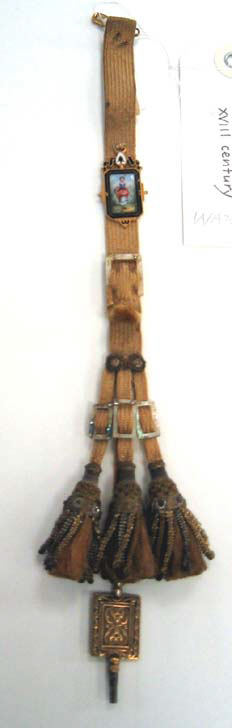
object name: fob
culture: french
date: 1701-1800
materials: metal, silk